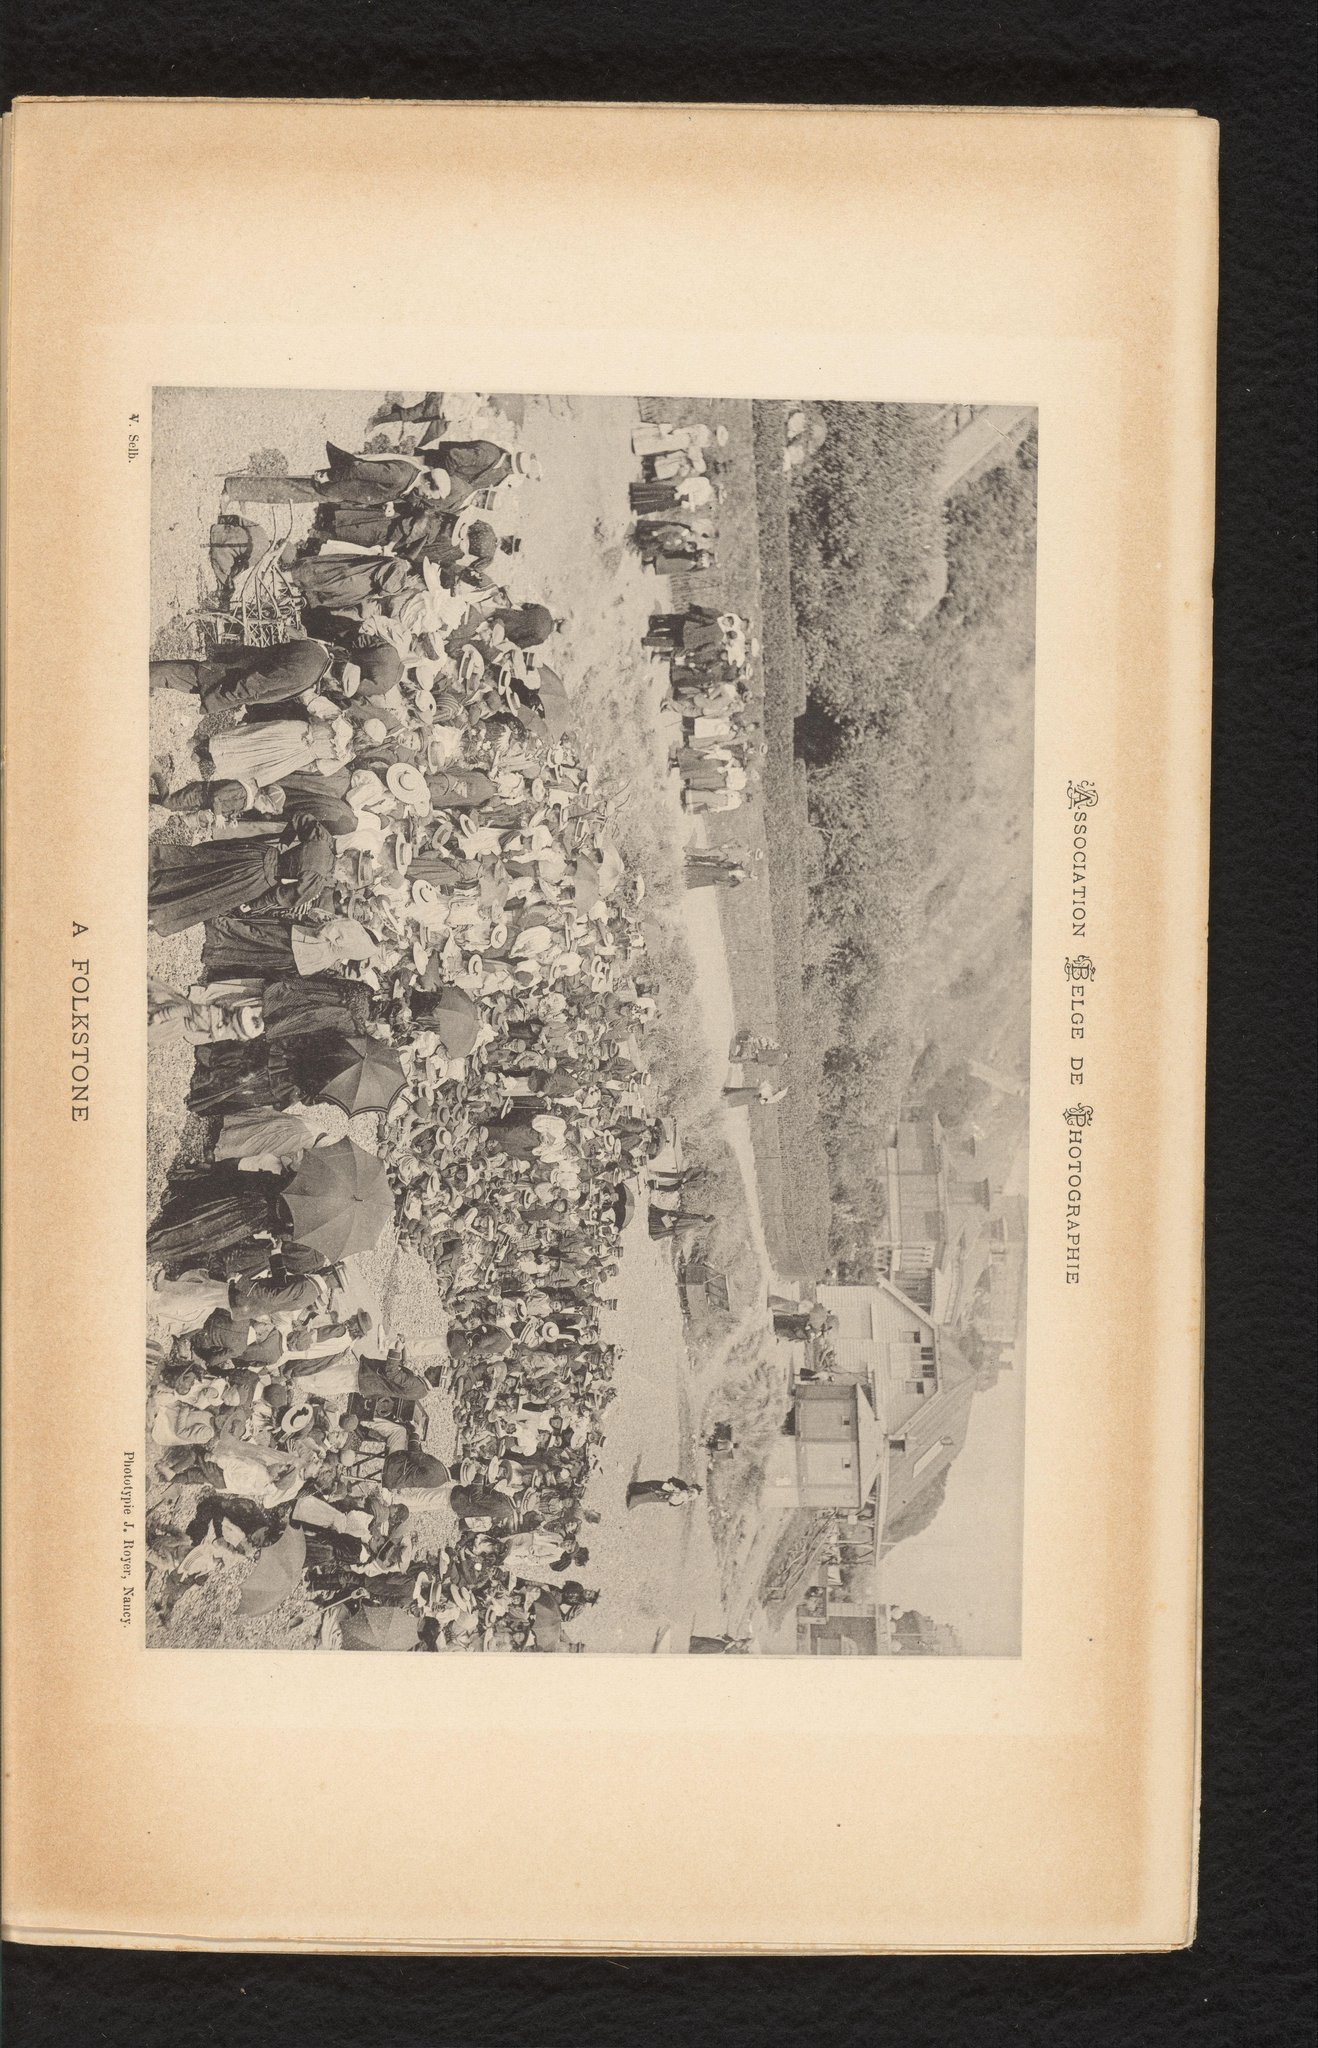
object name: page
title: Grote groep mensen op een veld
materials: paper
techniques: photograph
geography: nancy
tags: cultivated land (+ landscape with figures, staffage)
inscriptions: inscription: ‘Association Belge de Photographie 1889.’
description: Prent op derde ongenummerde pagina na pagina XVI.